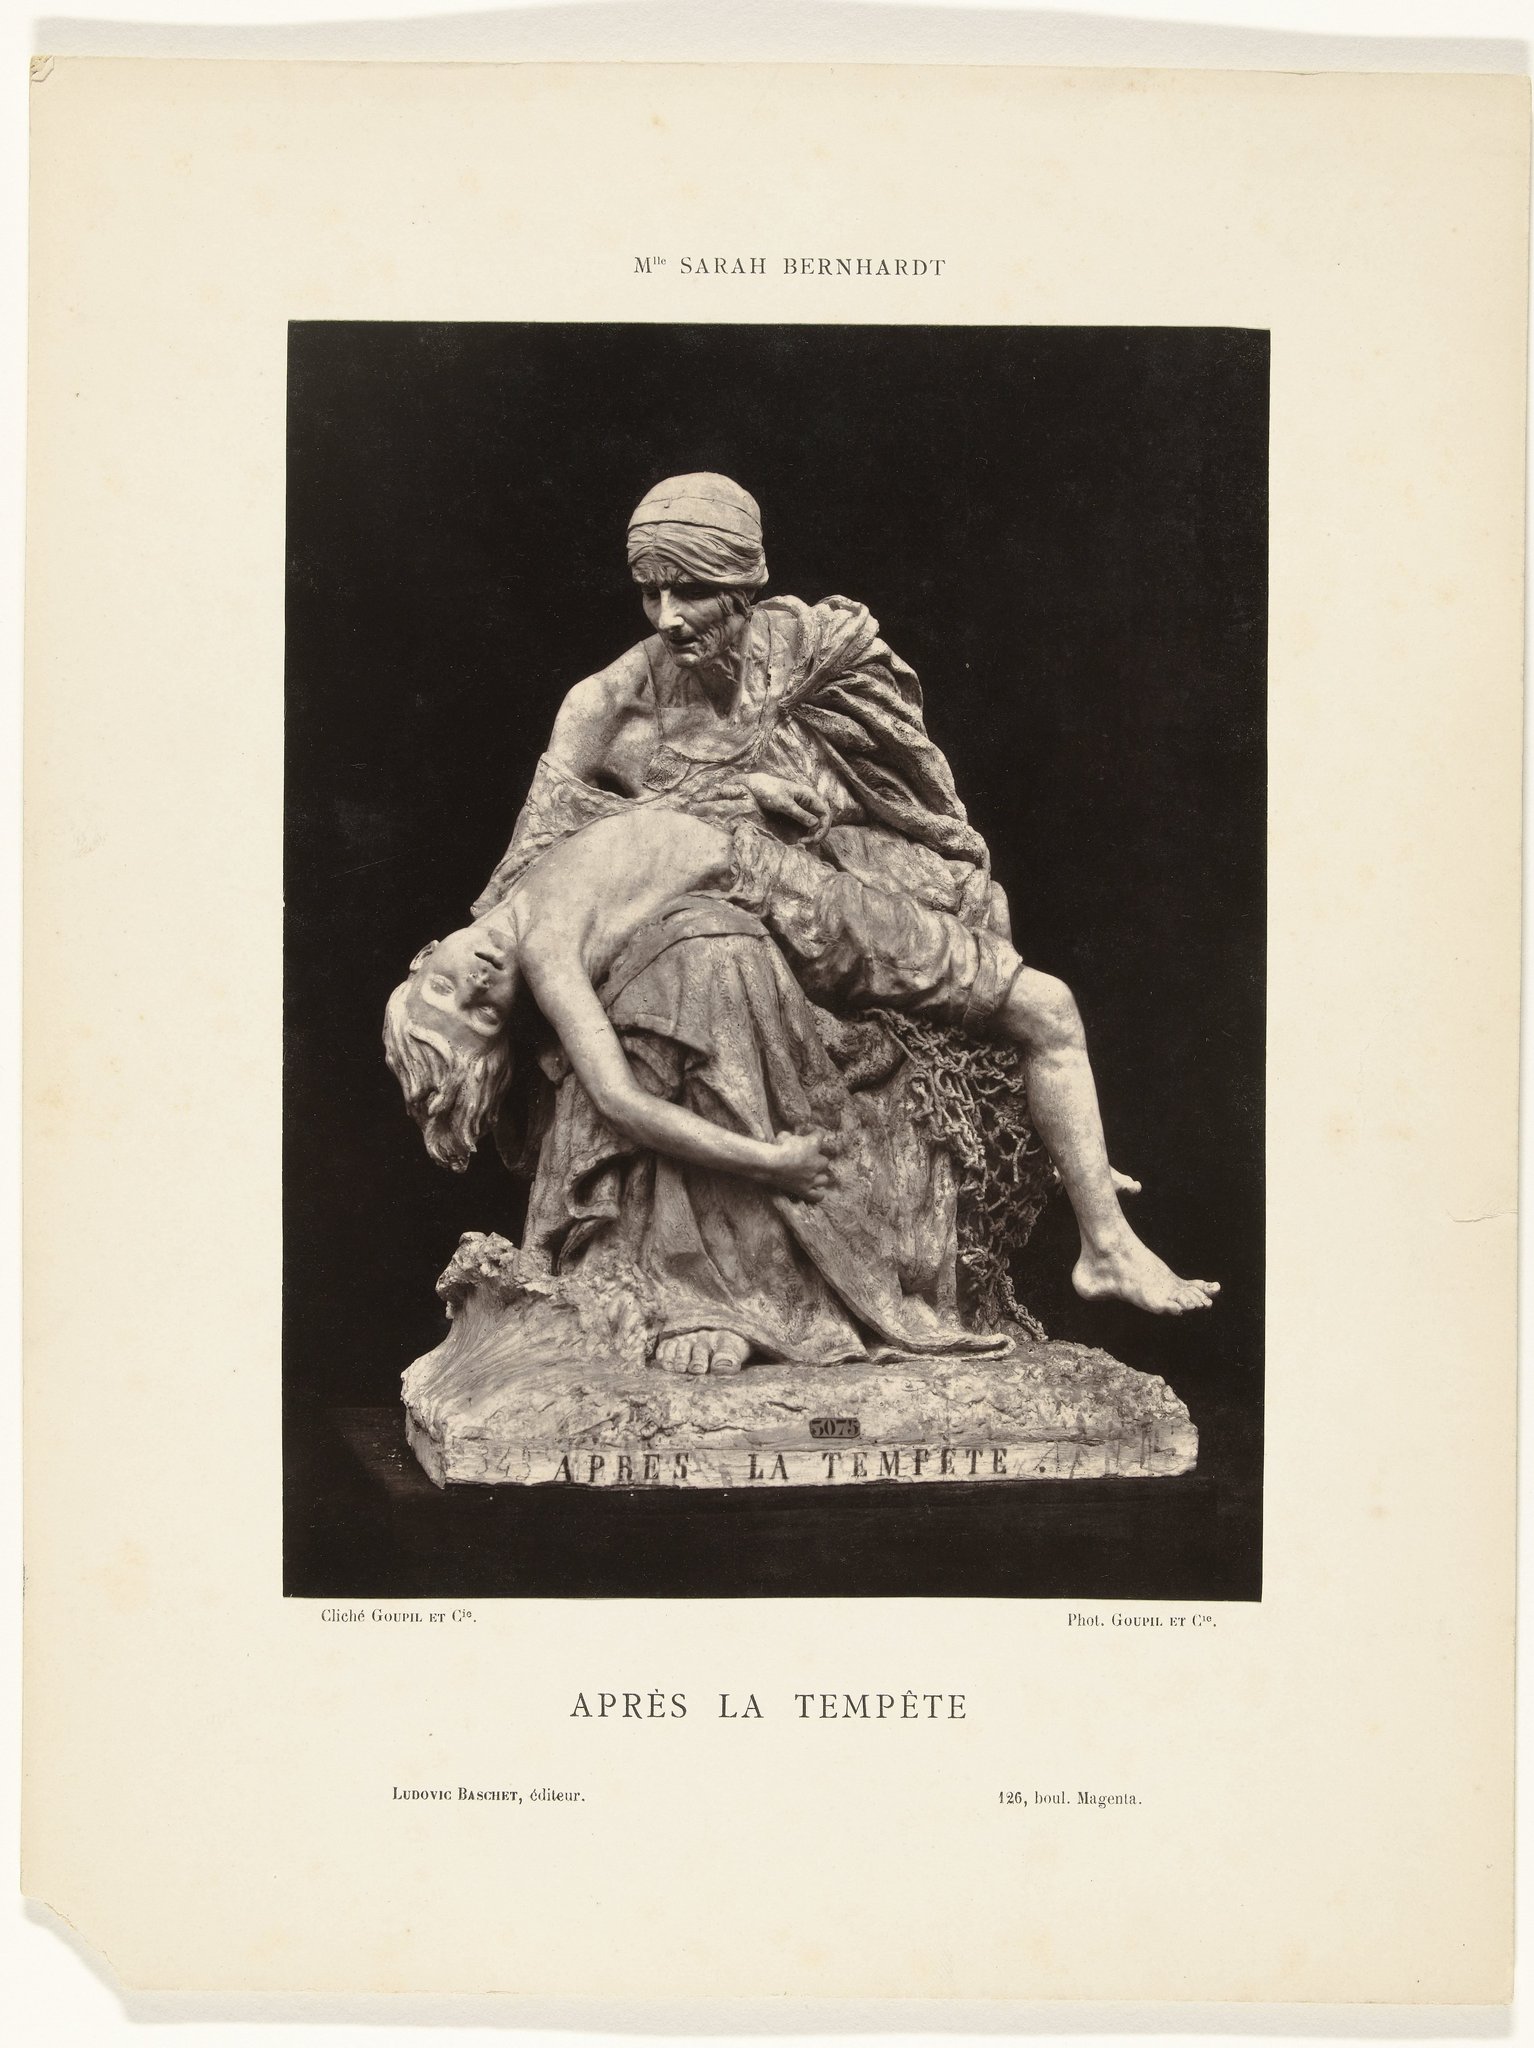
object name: photomechanical print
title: Après la Tempête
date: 1877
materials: cardboard, paper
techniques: woodburytype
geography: paris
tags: adult woman, grandchildren (second degree family relationships), sculpture, france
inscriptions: address: ‘12, boul. Magenta.’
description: Vrouw met kleinzoon op schoot, de jongen is gewikkeld in visnetten.